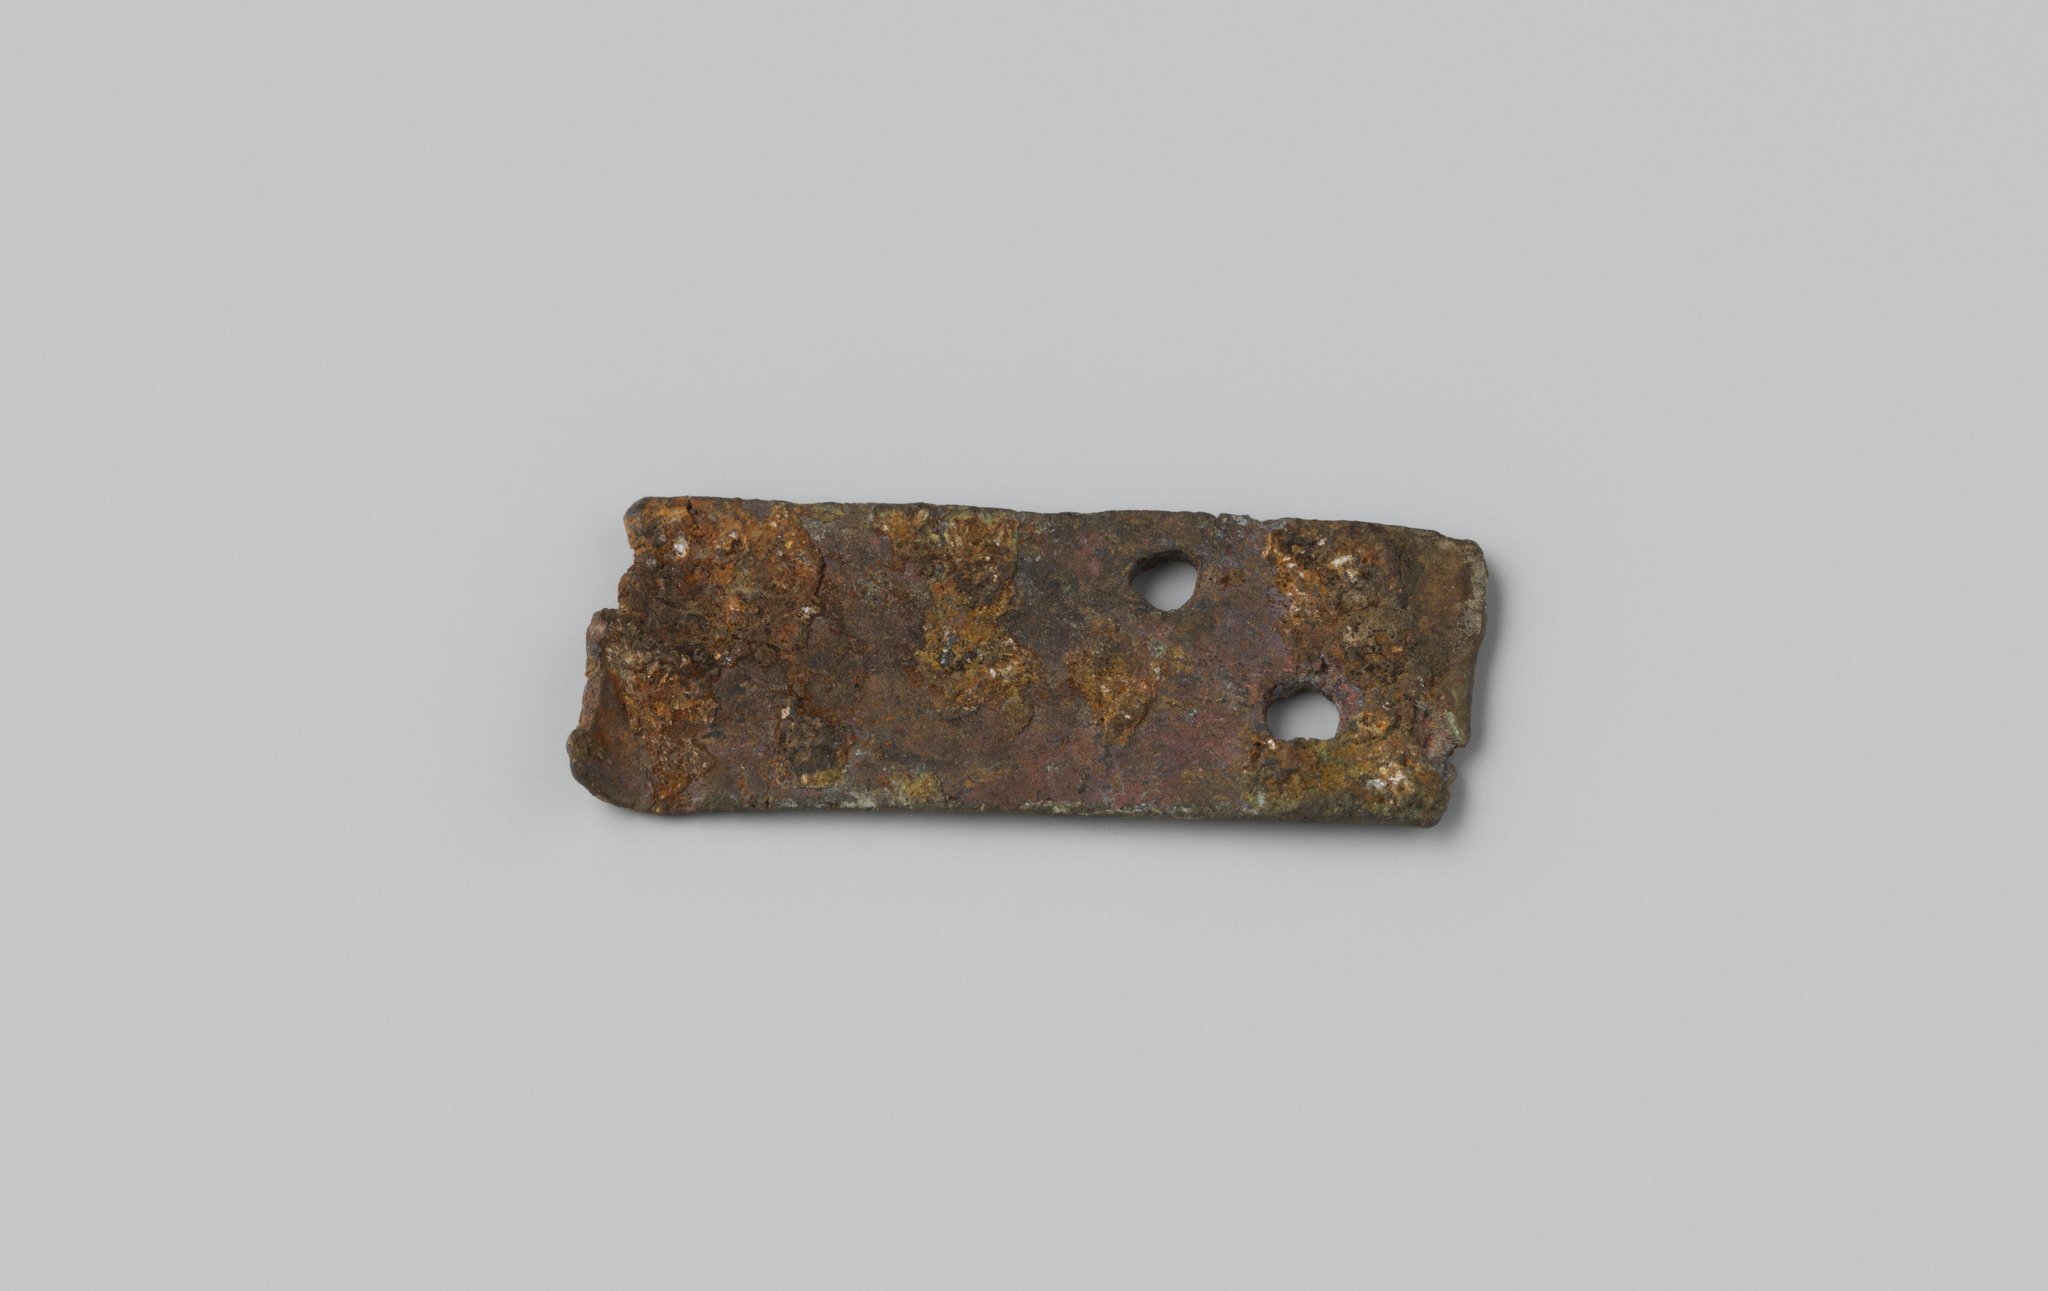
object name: part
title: Onderdeel of hulpstuk afkomstig uit het wrak van de Oost-Indiëvaarder Hollandia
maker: Anonymous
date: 1700-1743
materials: copper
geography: netherlands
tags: verenigde oostindische compagnie, hollandia (schip)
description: Strip-shaped fitting; fragm, sim. 80H947, 2 holes diagonally at one end.